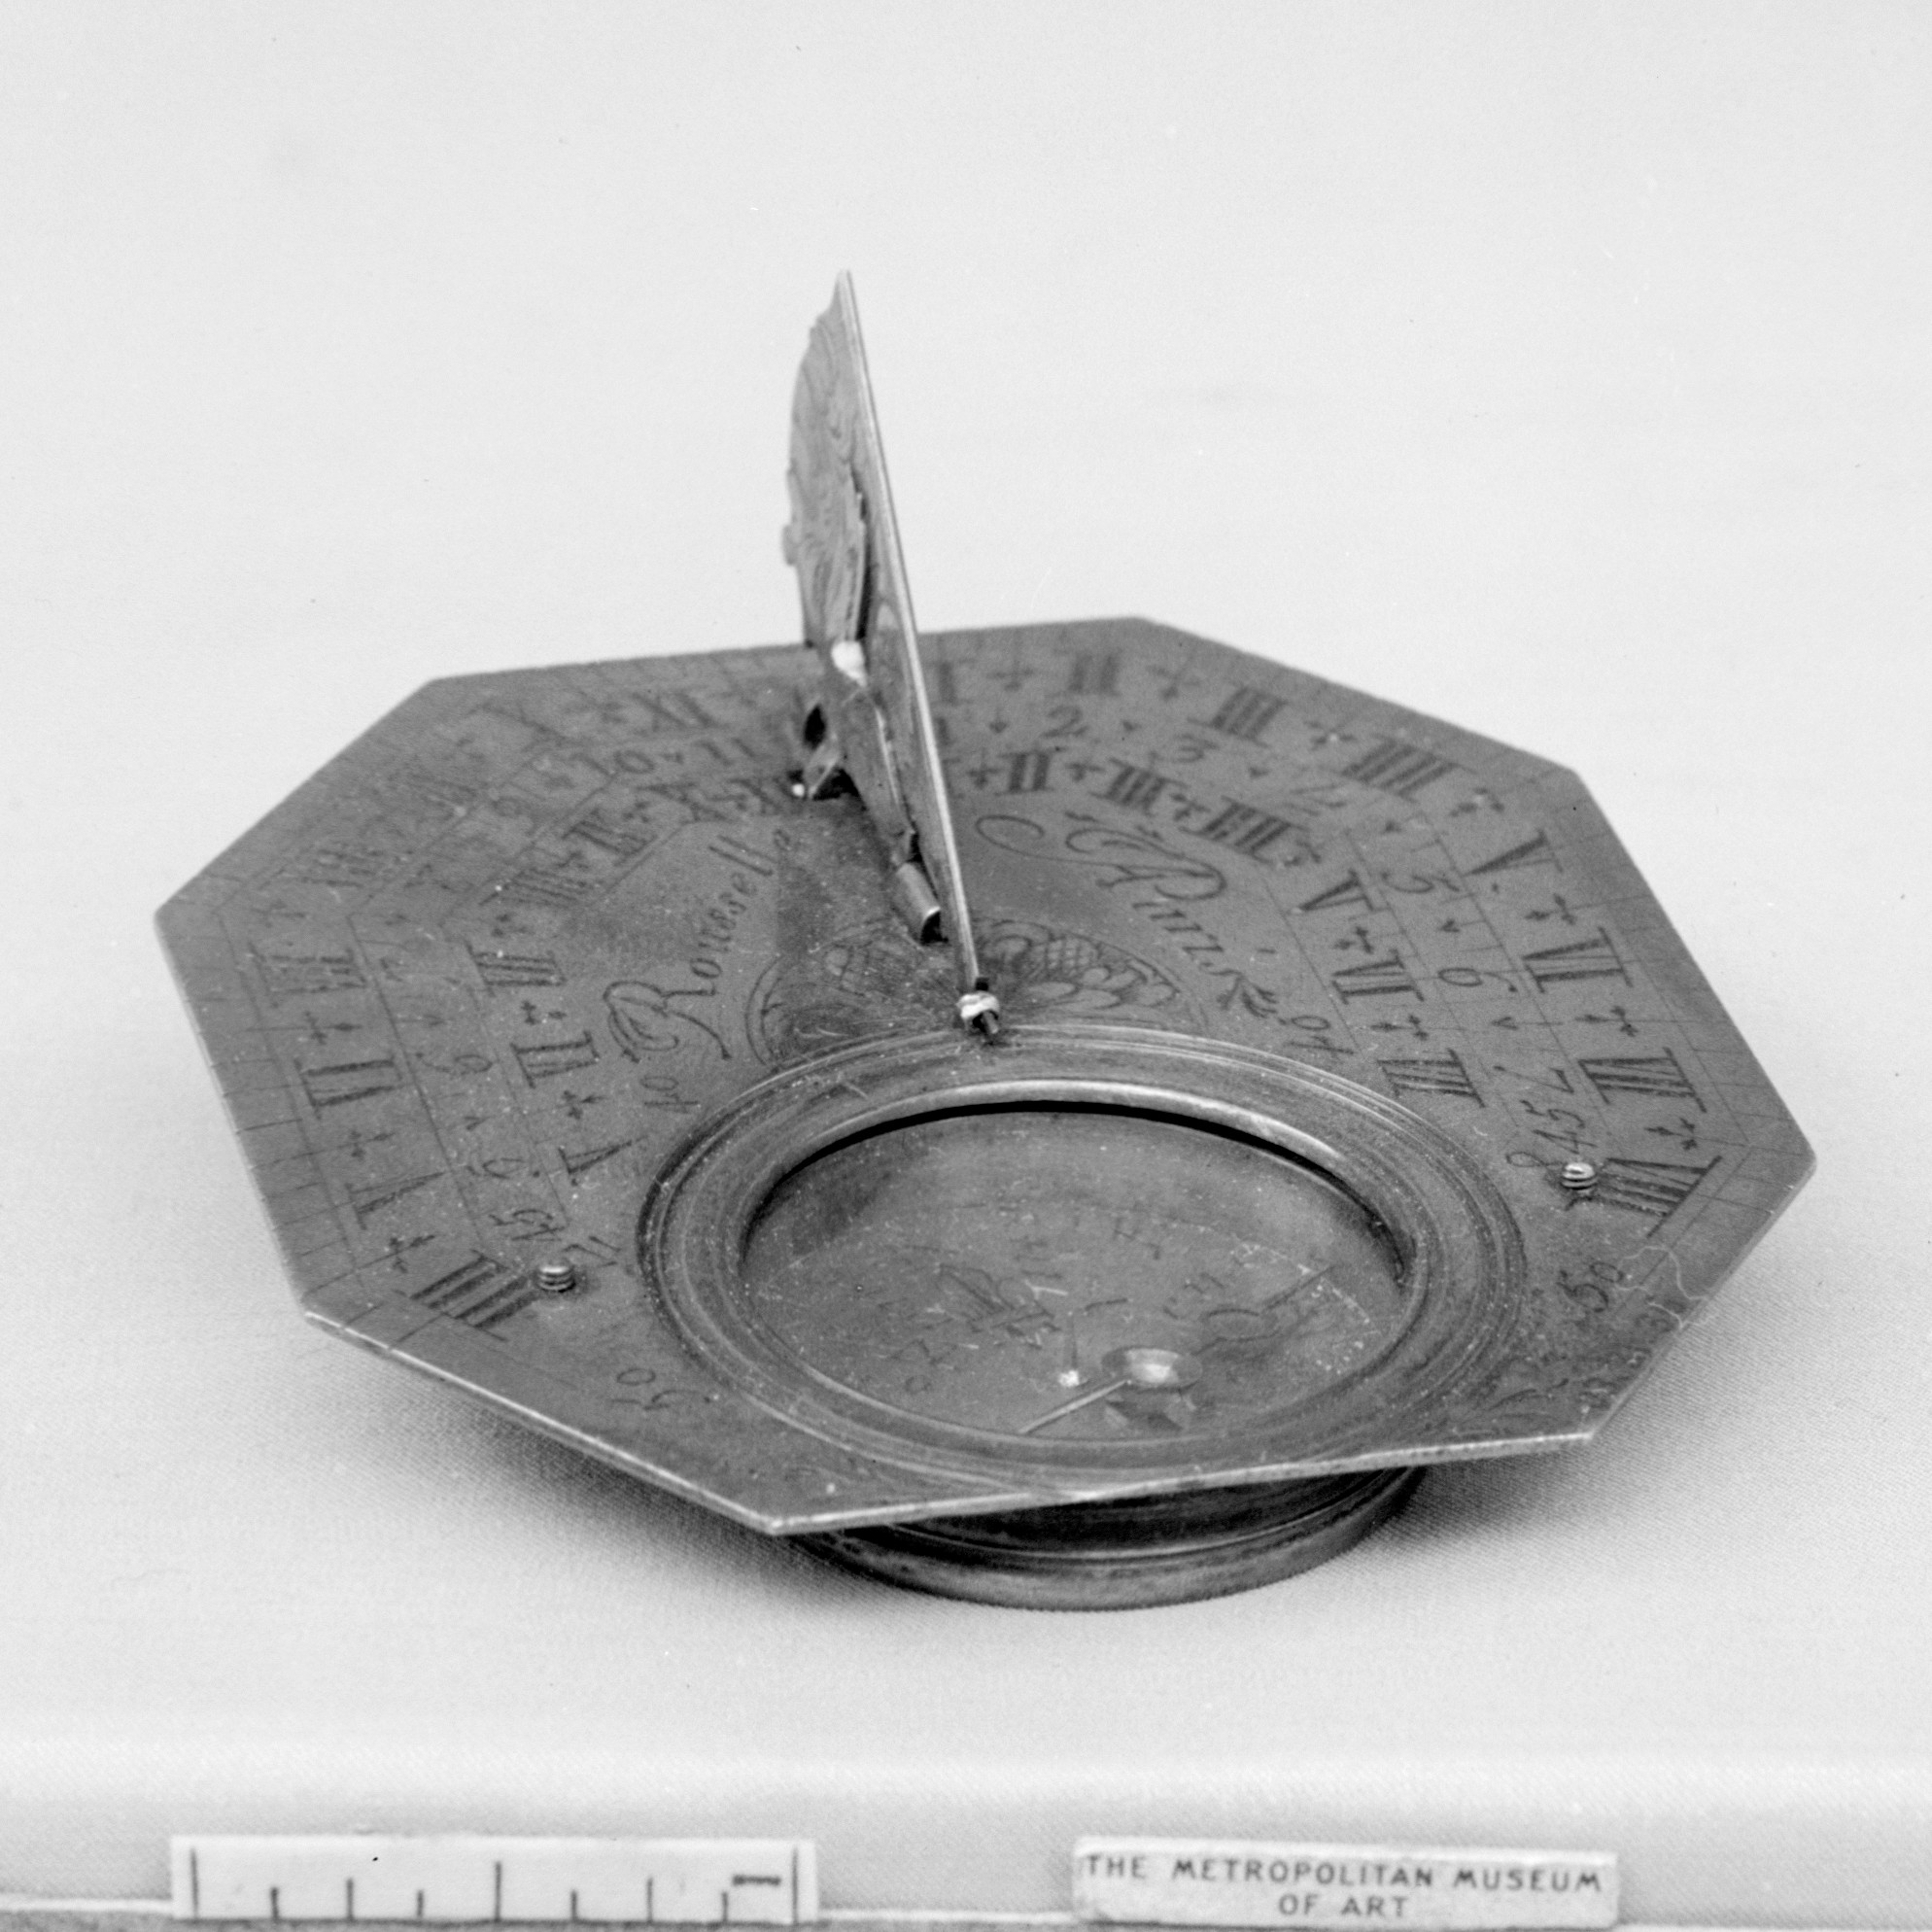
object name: portable horizontal sundial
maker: rousselle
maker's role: maker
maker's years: 1675-1775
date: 1701-1750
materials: brass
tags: sundials